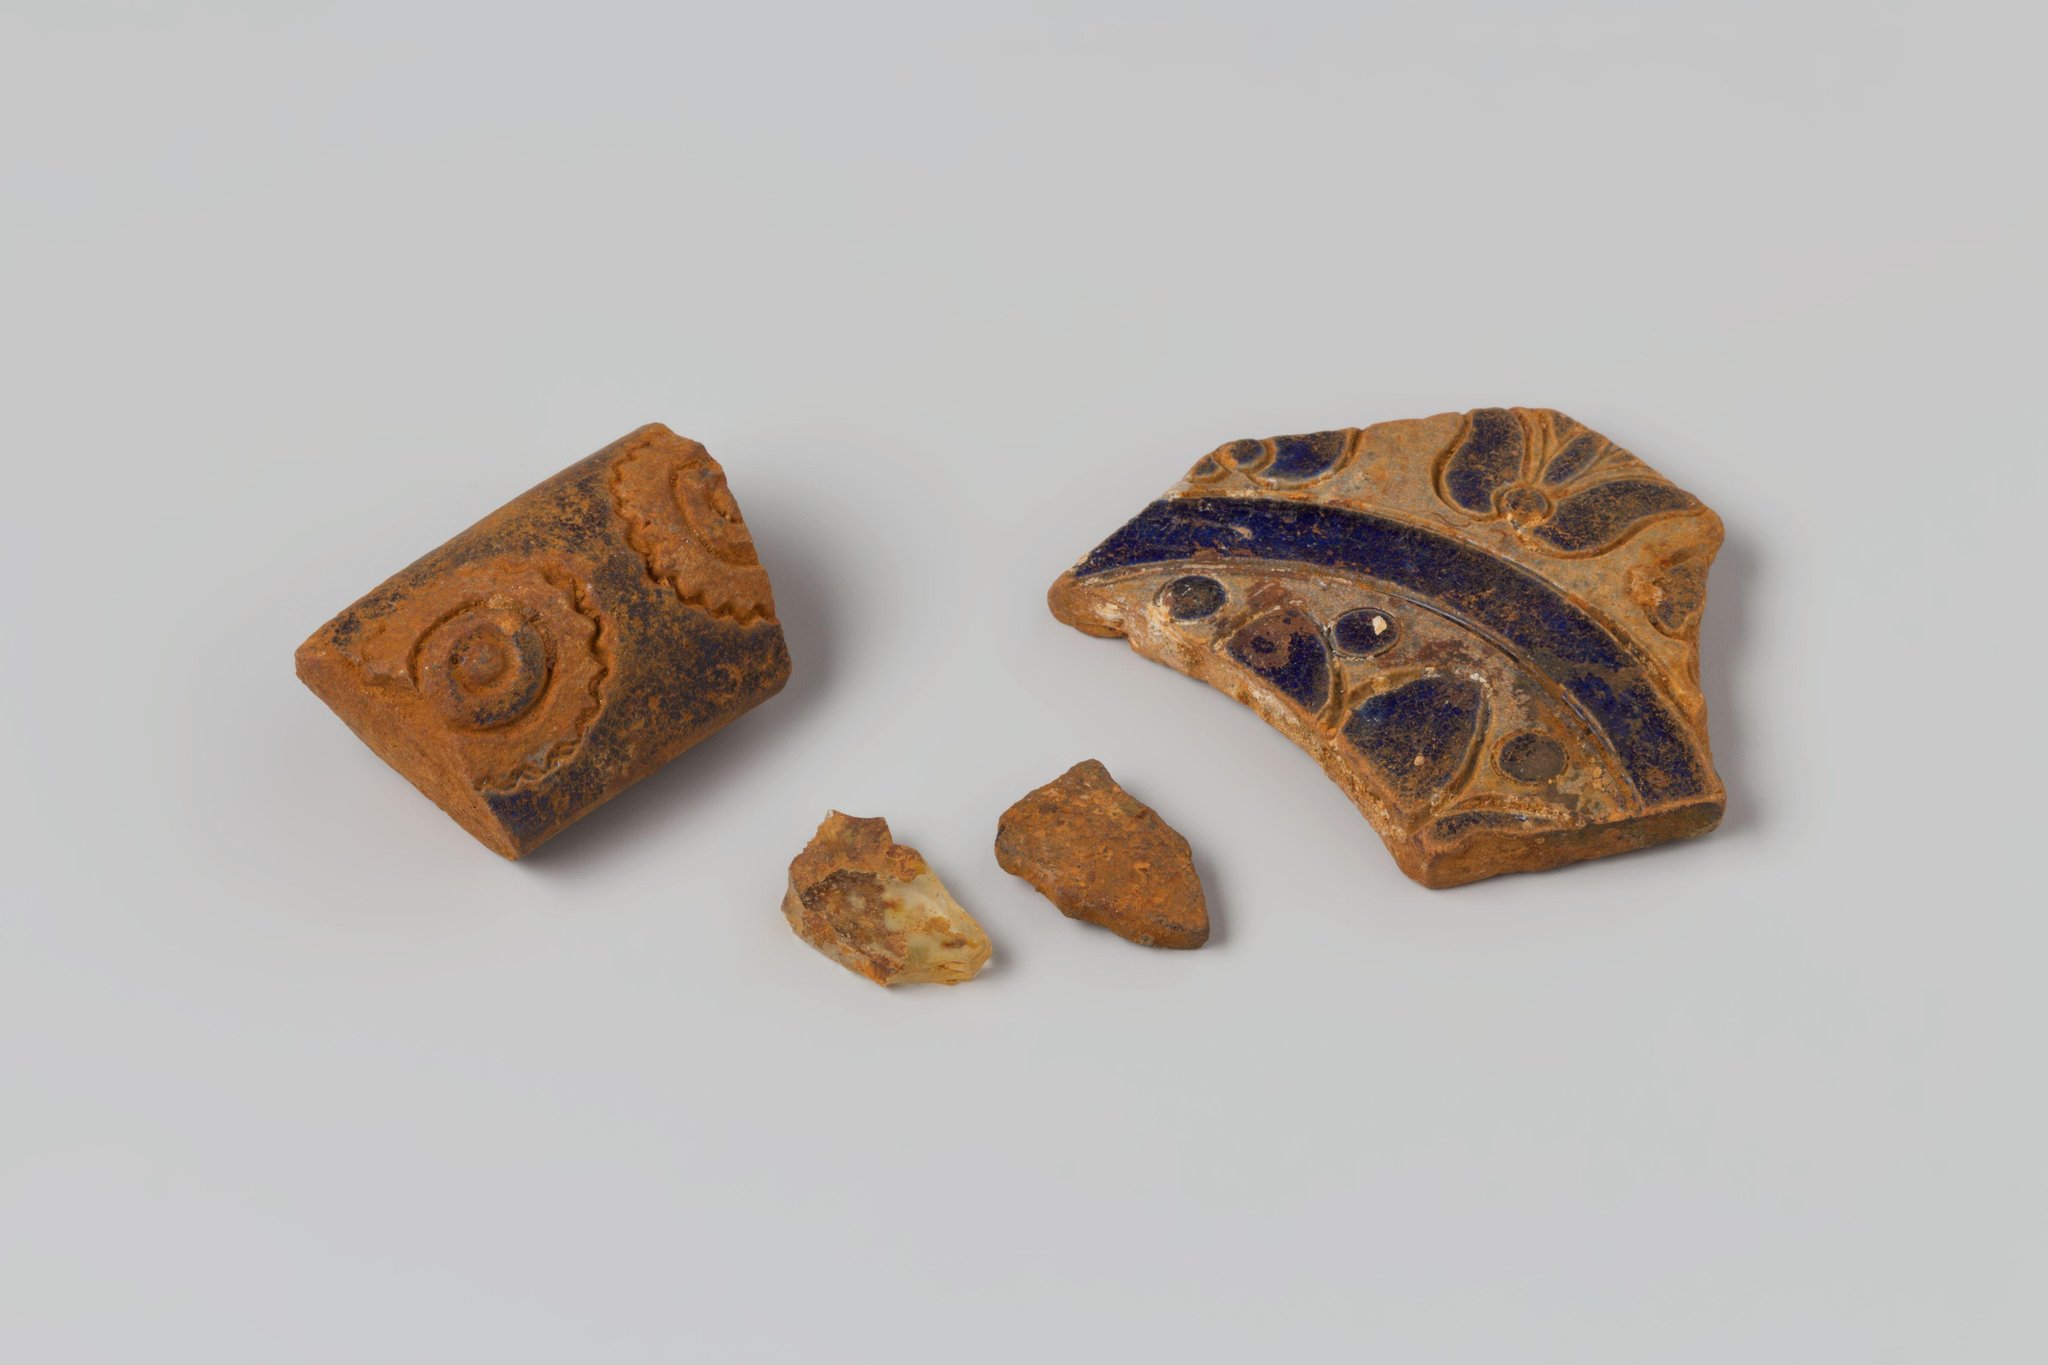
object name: sherd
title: Scherven van potten en een glasscherf uit het wrak van de Oost-Indiëvaarder Hollandia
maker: Anonymous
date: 1700-1743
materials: glass, stoneware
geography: westerwald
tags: verenigde oostindische compagnie, hollandia (schip), annet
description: Stoneware, Rhenish, Westerwald, pot: fragm of handle with relieved decoration; fragm of body, sim. NG 1980-27H2624).